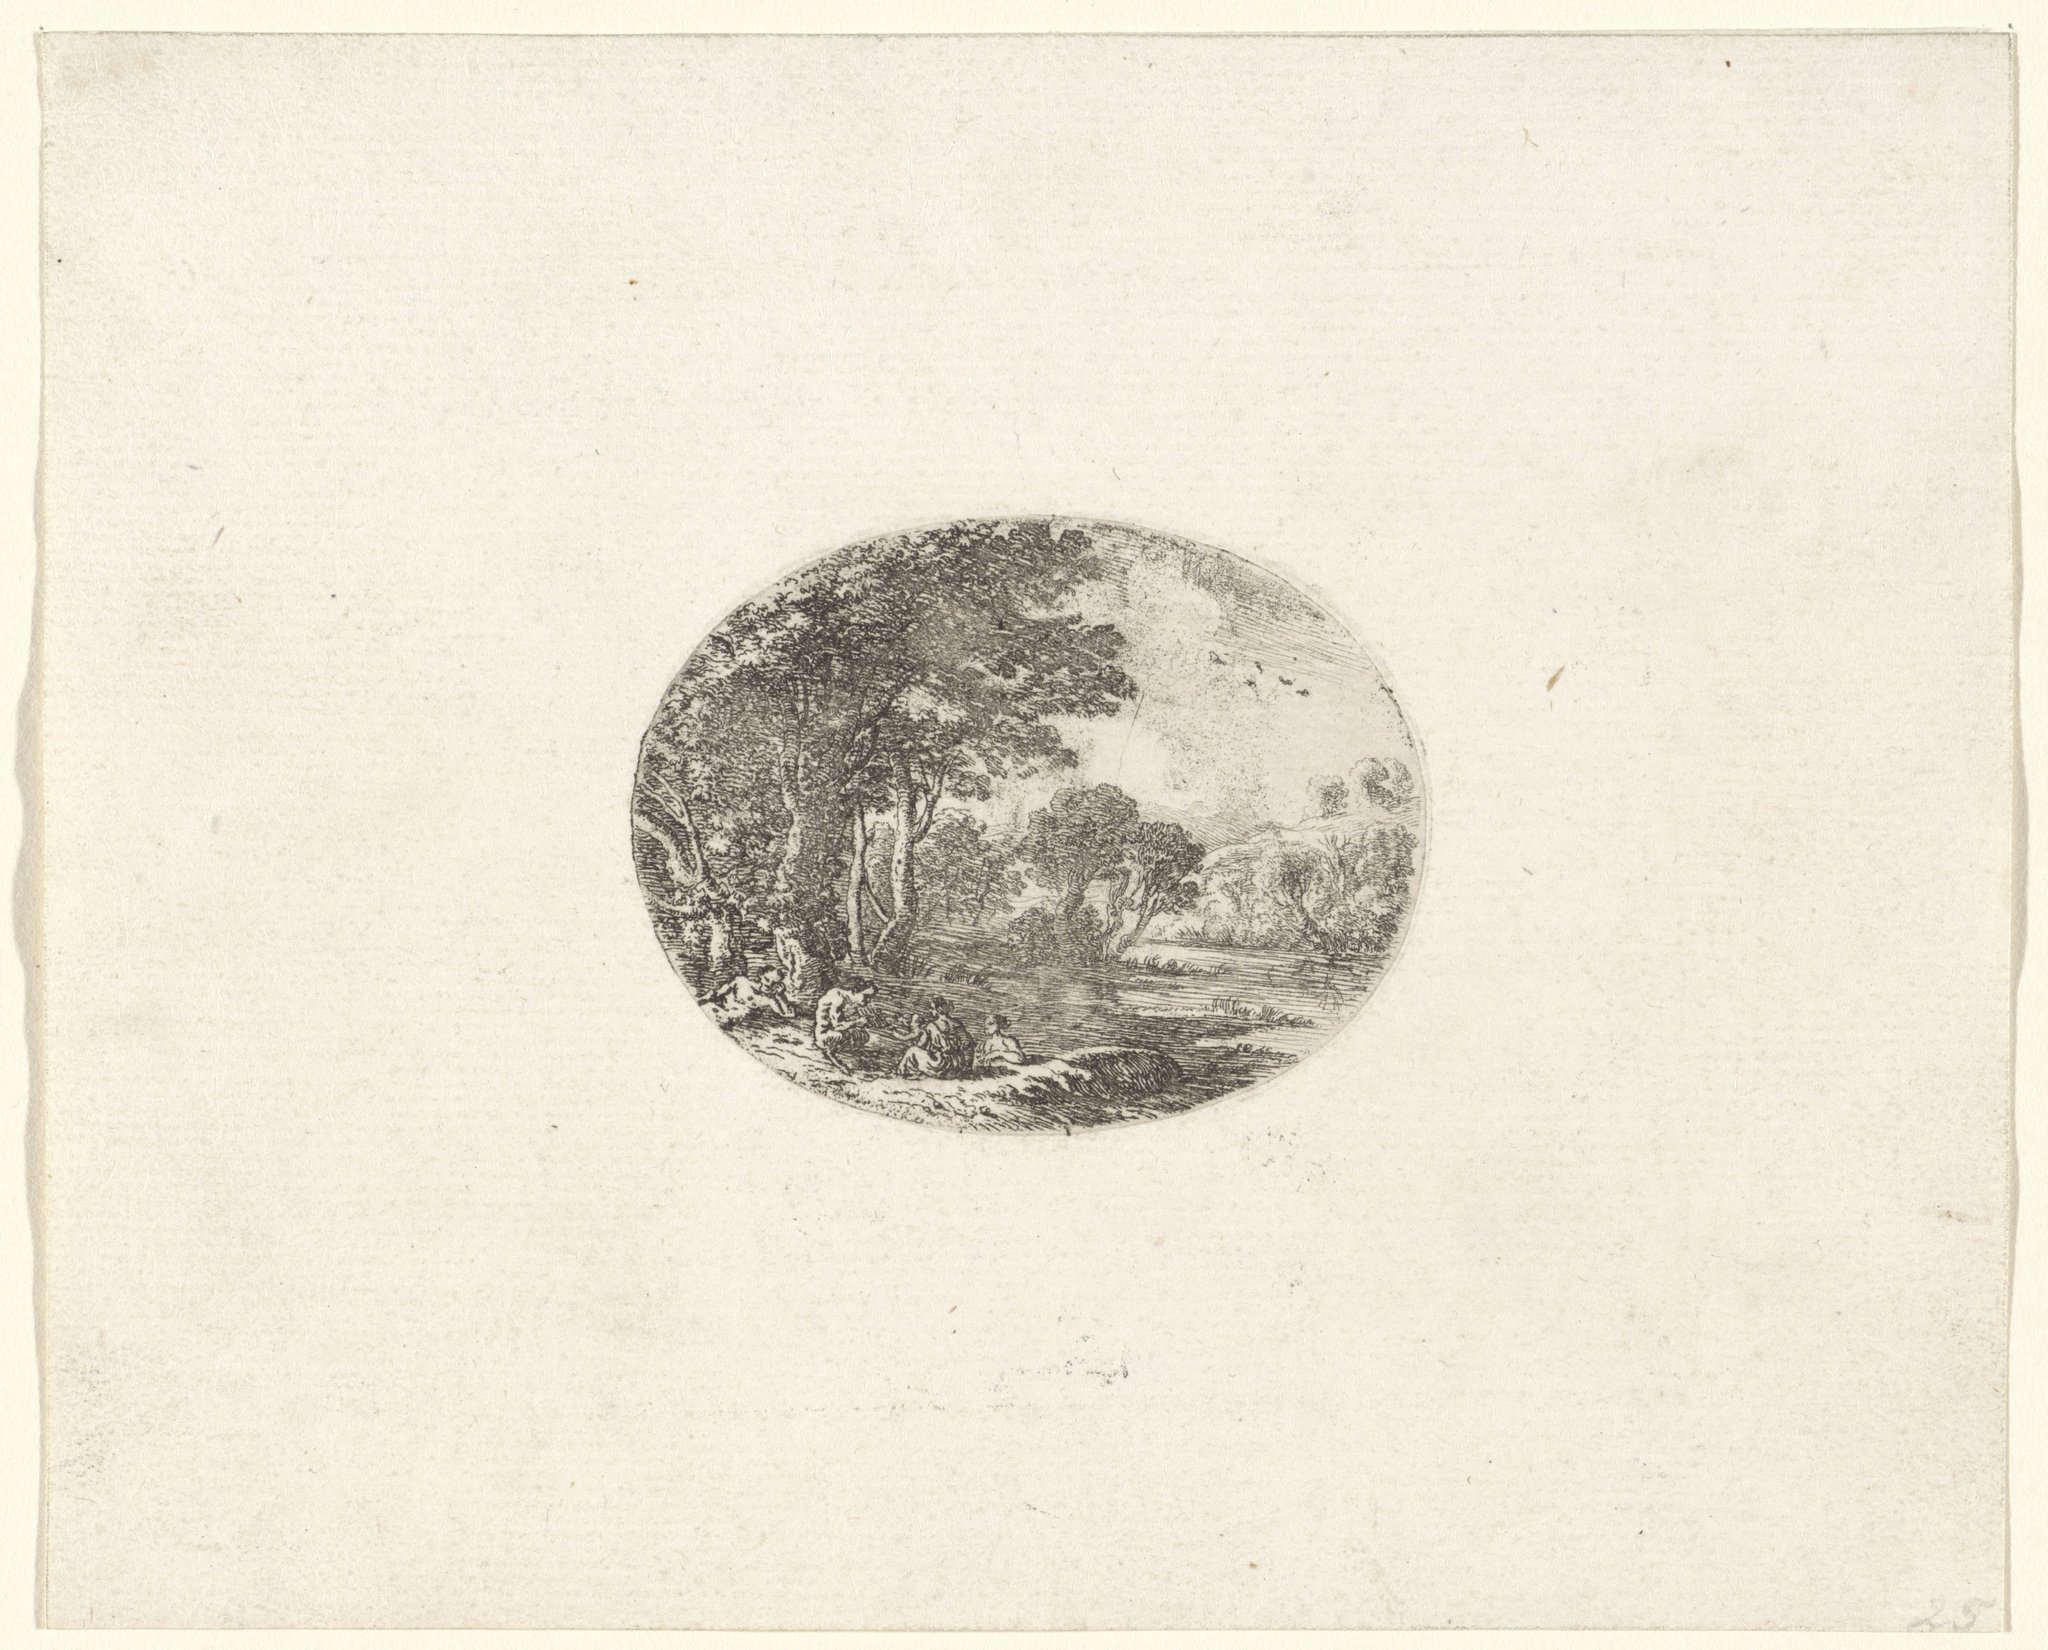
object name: print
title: Sater bespeelt een panfluit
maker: herman van swanevelt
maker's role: draughtsman, painter, print maker, publisher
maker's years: 1603-1655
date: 1623-1655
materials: paper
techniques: etching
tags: one person playing wind instrument - cc - out of doors, panpipes, non-aggressive, friendly or neutral activities and relationships of satyr(s), nymphs (in general); 'ninfe in commune' (ripa), satyr(s) (in general)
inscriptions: collector's mark: Lugt 240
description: Een sater bespeelt een panfluit te midden van een andere sater, twee nimfen en een jong kind of sater.